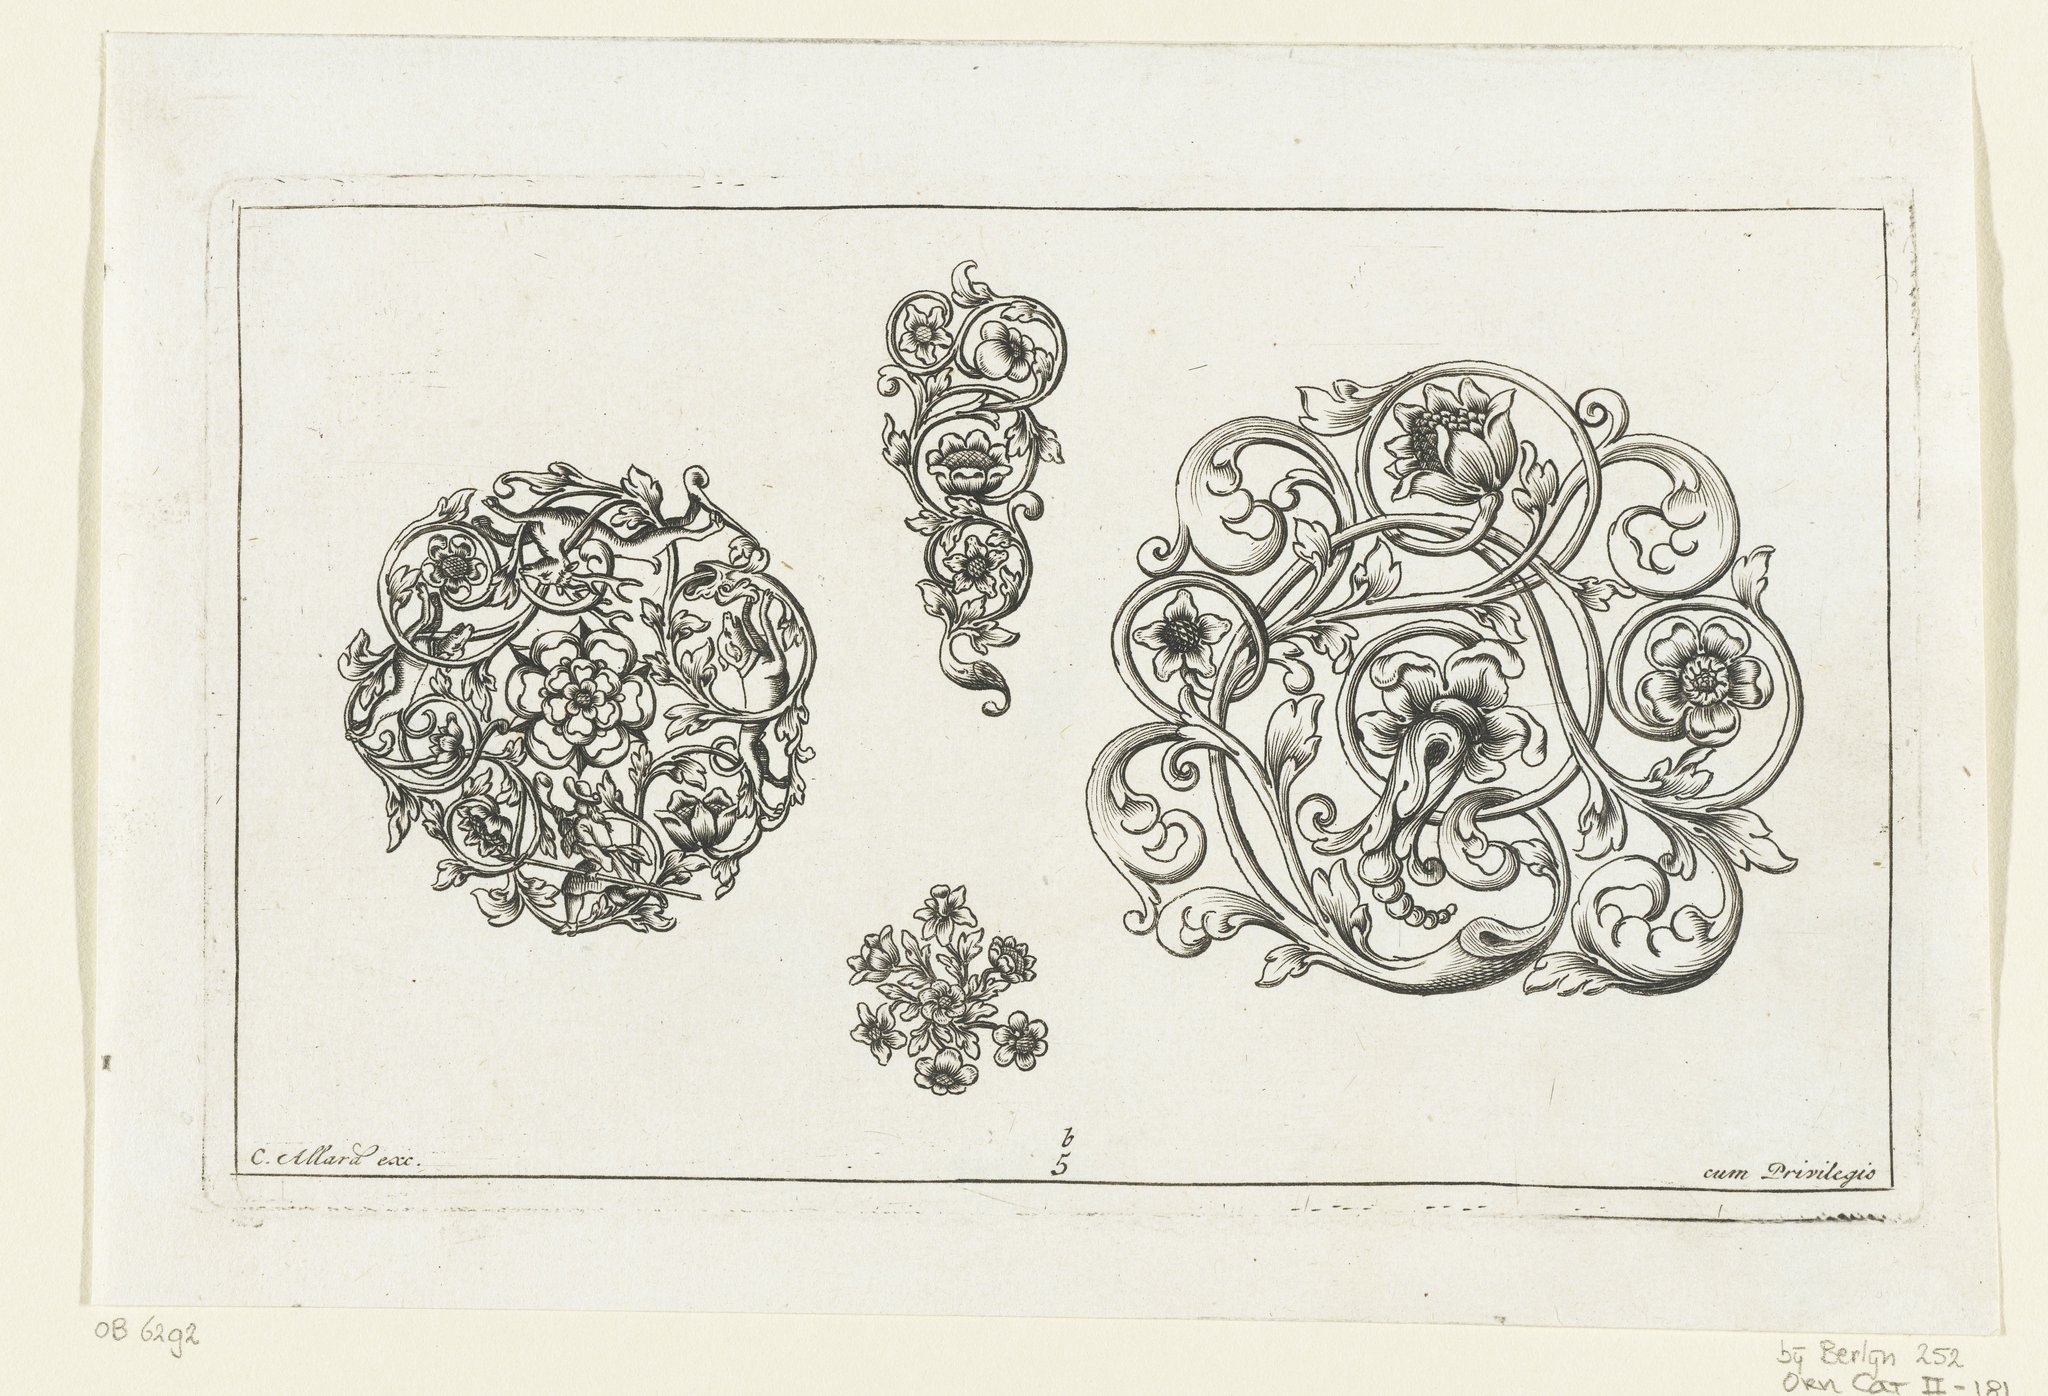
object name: print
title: Doorgebroke Zilver-Smids werk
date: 1690-1700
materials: paper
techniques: engraving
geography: amsterdam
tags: ornament derived from plant forms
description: In het motief links zijn een jager, twee honden en een hert verwerkt. Blad uit tweede serie van 6 bladen met voorbeelden van ornamenten voor zilversmeden.